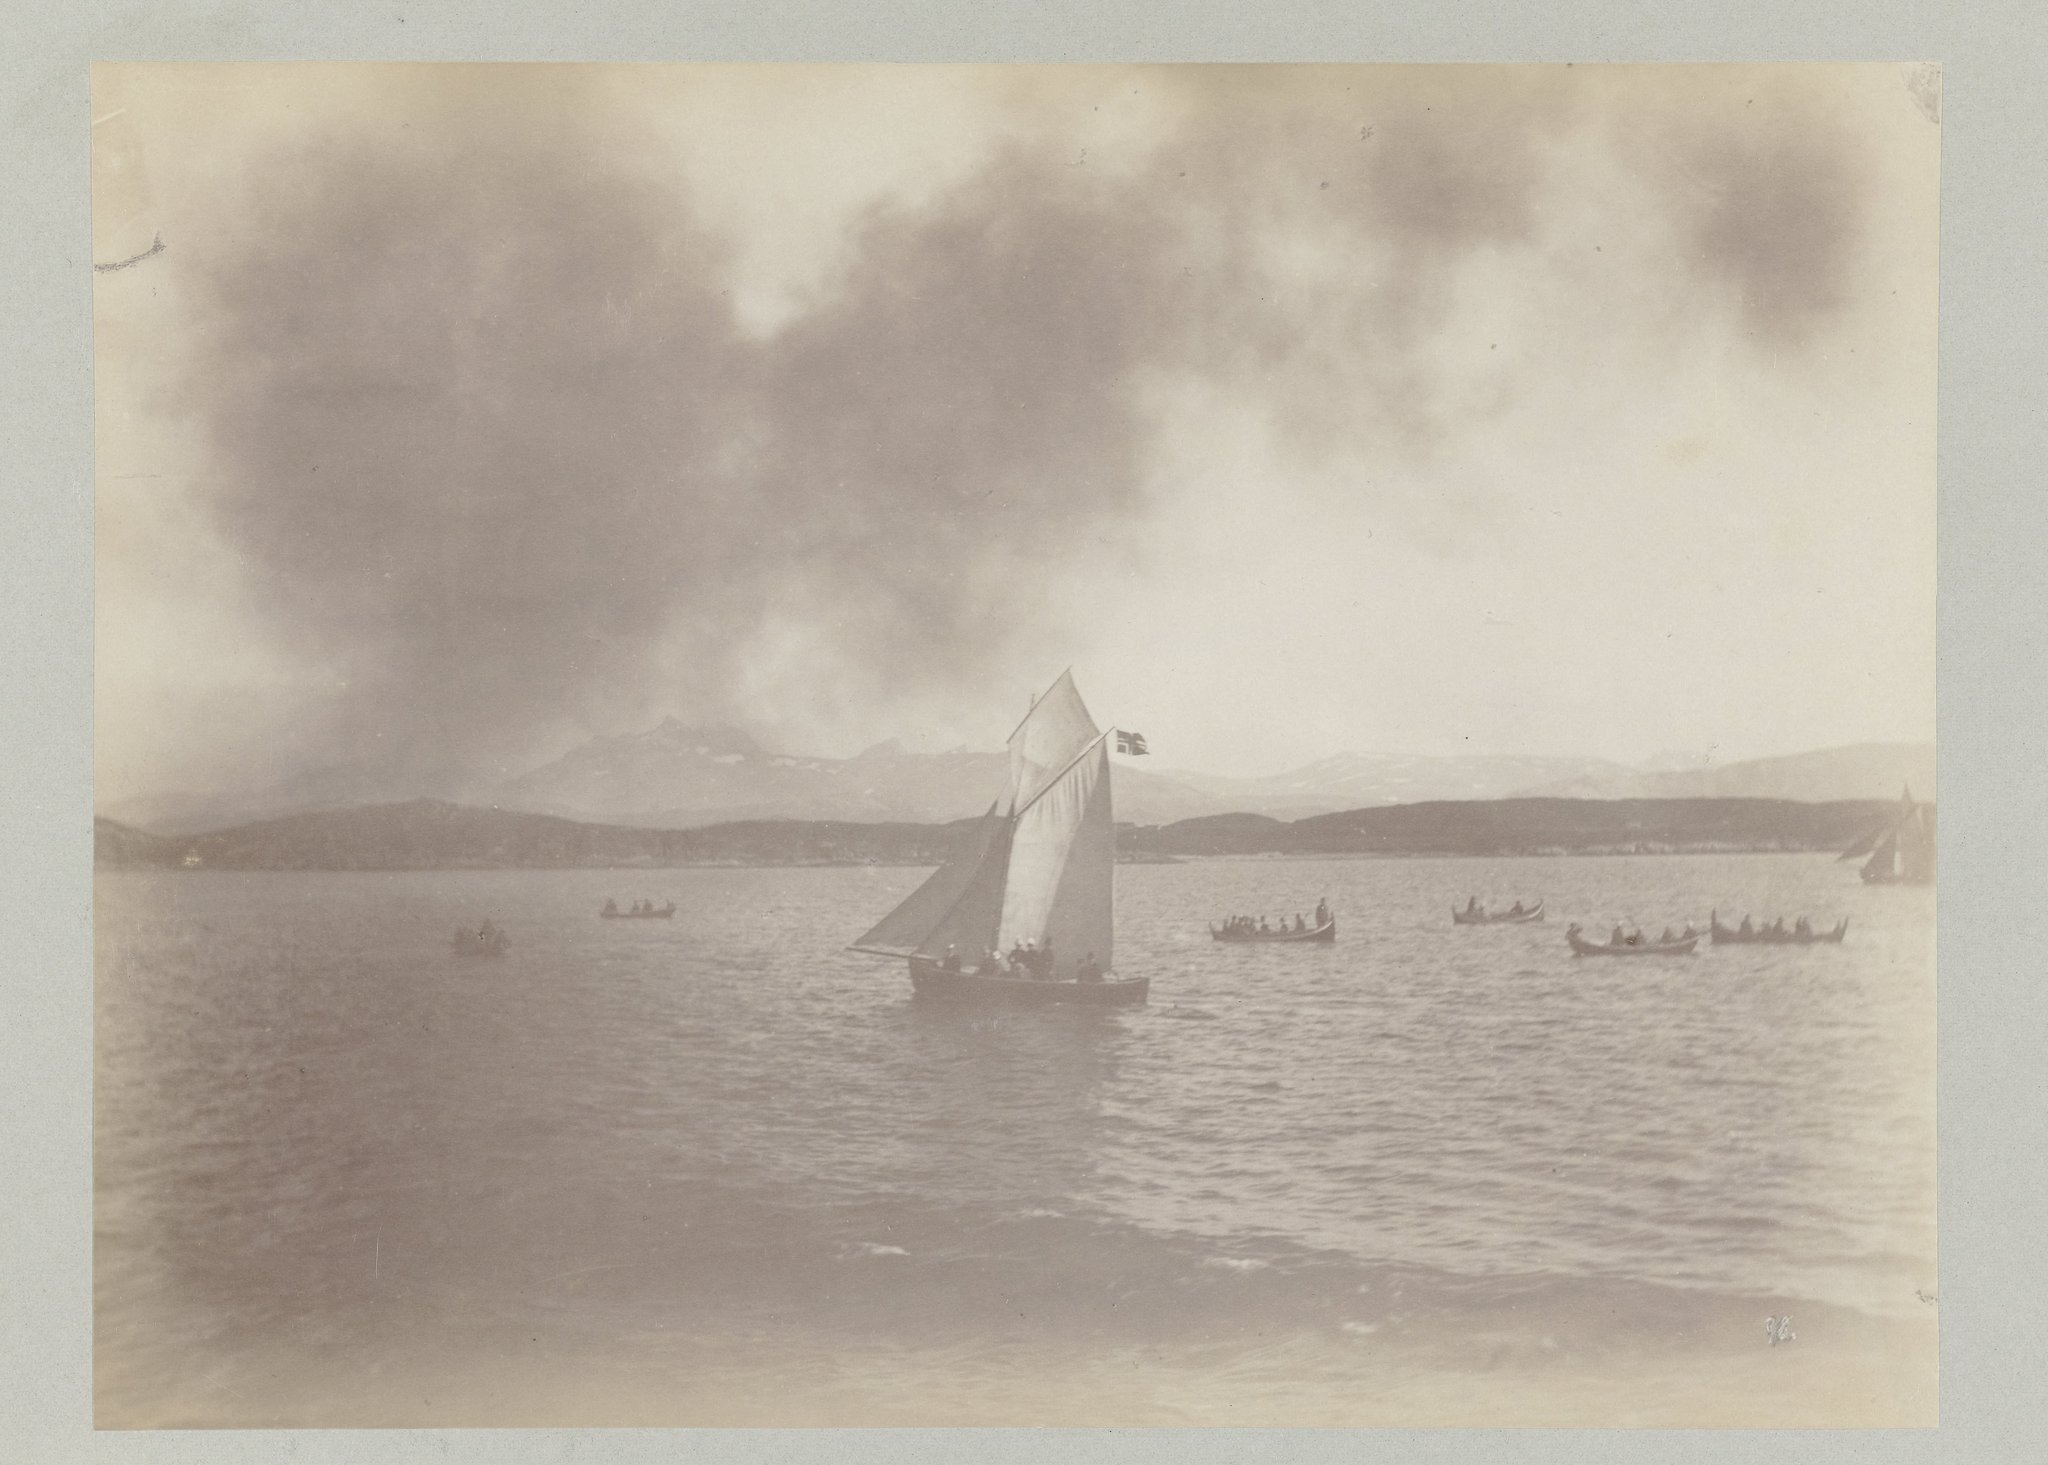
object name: photograph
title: Weiterreise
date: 1807-1889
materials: cardboard, paper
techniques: albumen print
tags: wilhelm ii (keizer van duitsland), norway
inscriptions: number: ‘25’, number: ‘98’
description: De afdruk van de foto is rond, het papier vierkant